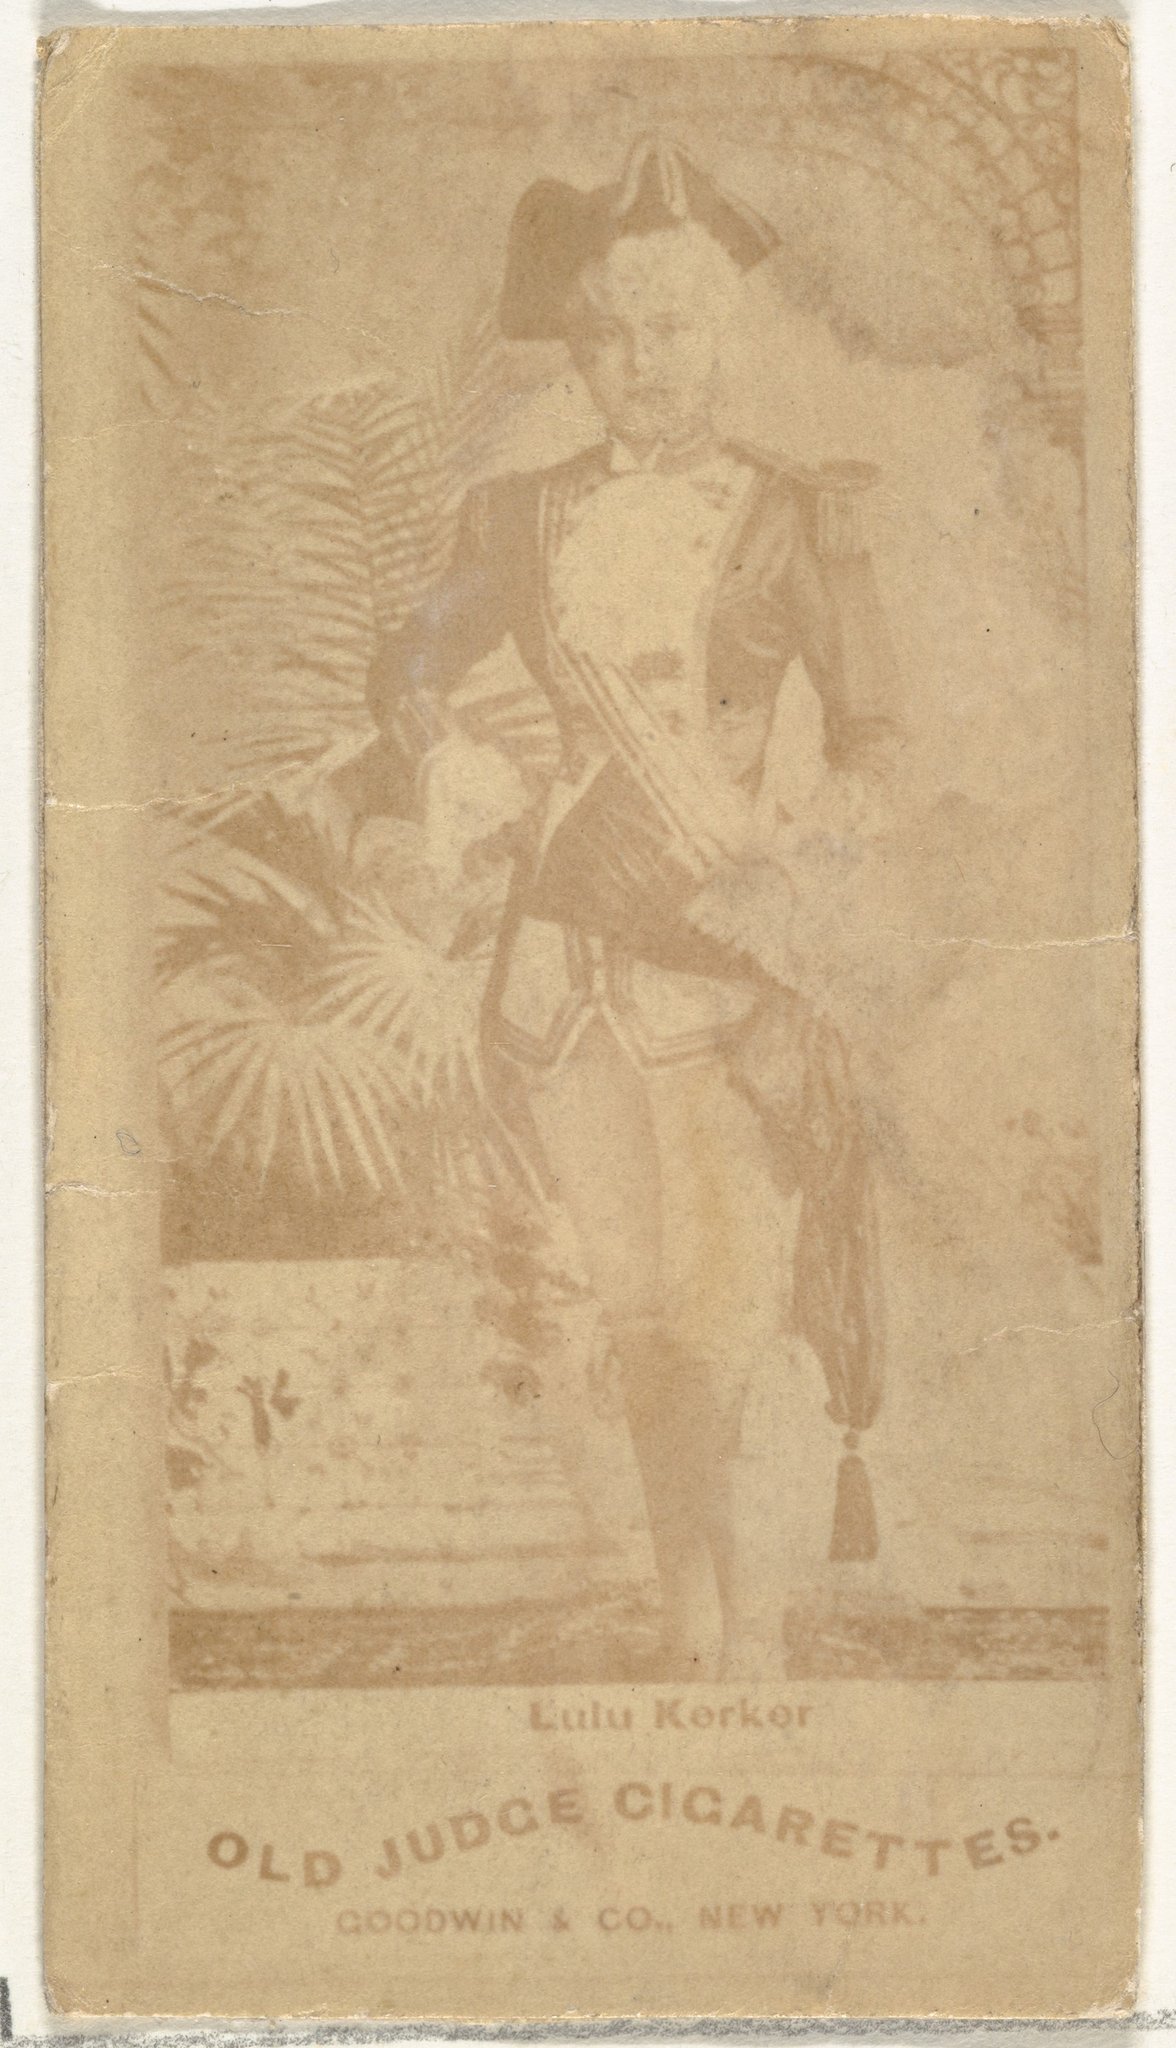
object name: photograph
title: Lulu Kerker, from the Actors and Actresses series (N171) for Old Judge Cigarettes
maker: goodwin & company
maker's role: publisher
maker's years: 1850-1950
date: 1886-1890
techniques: albumen silver print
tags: portraits,women,actresses